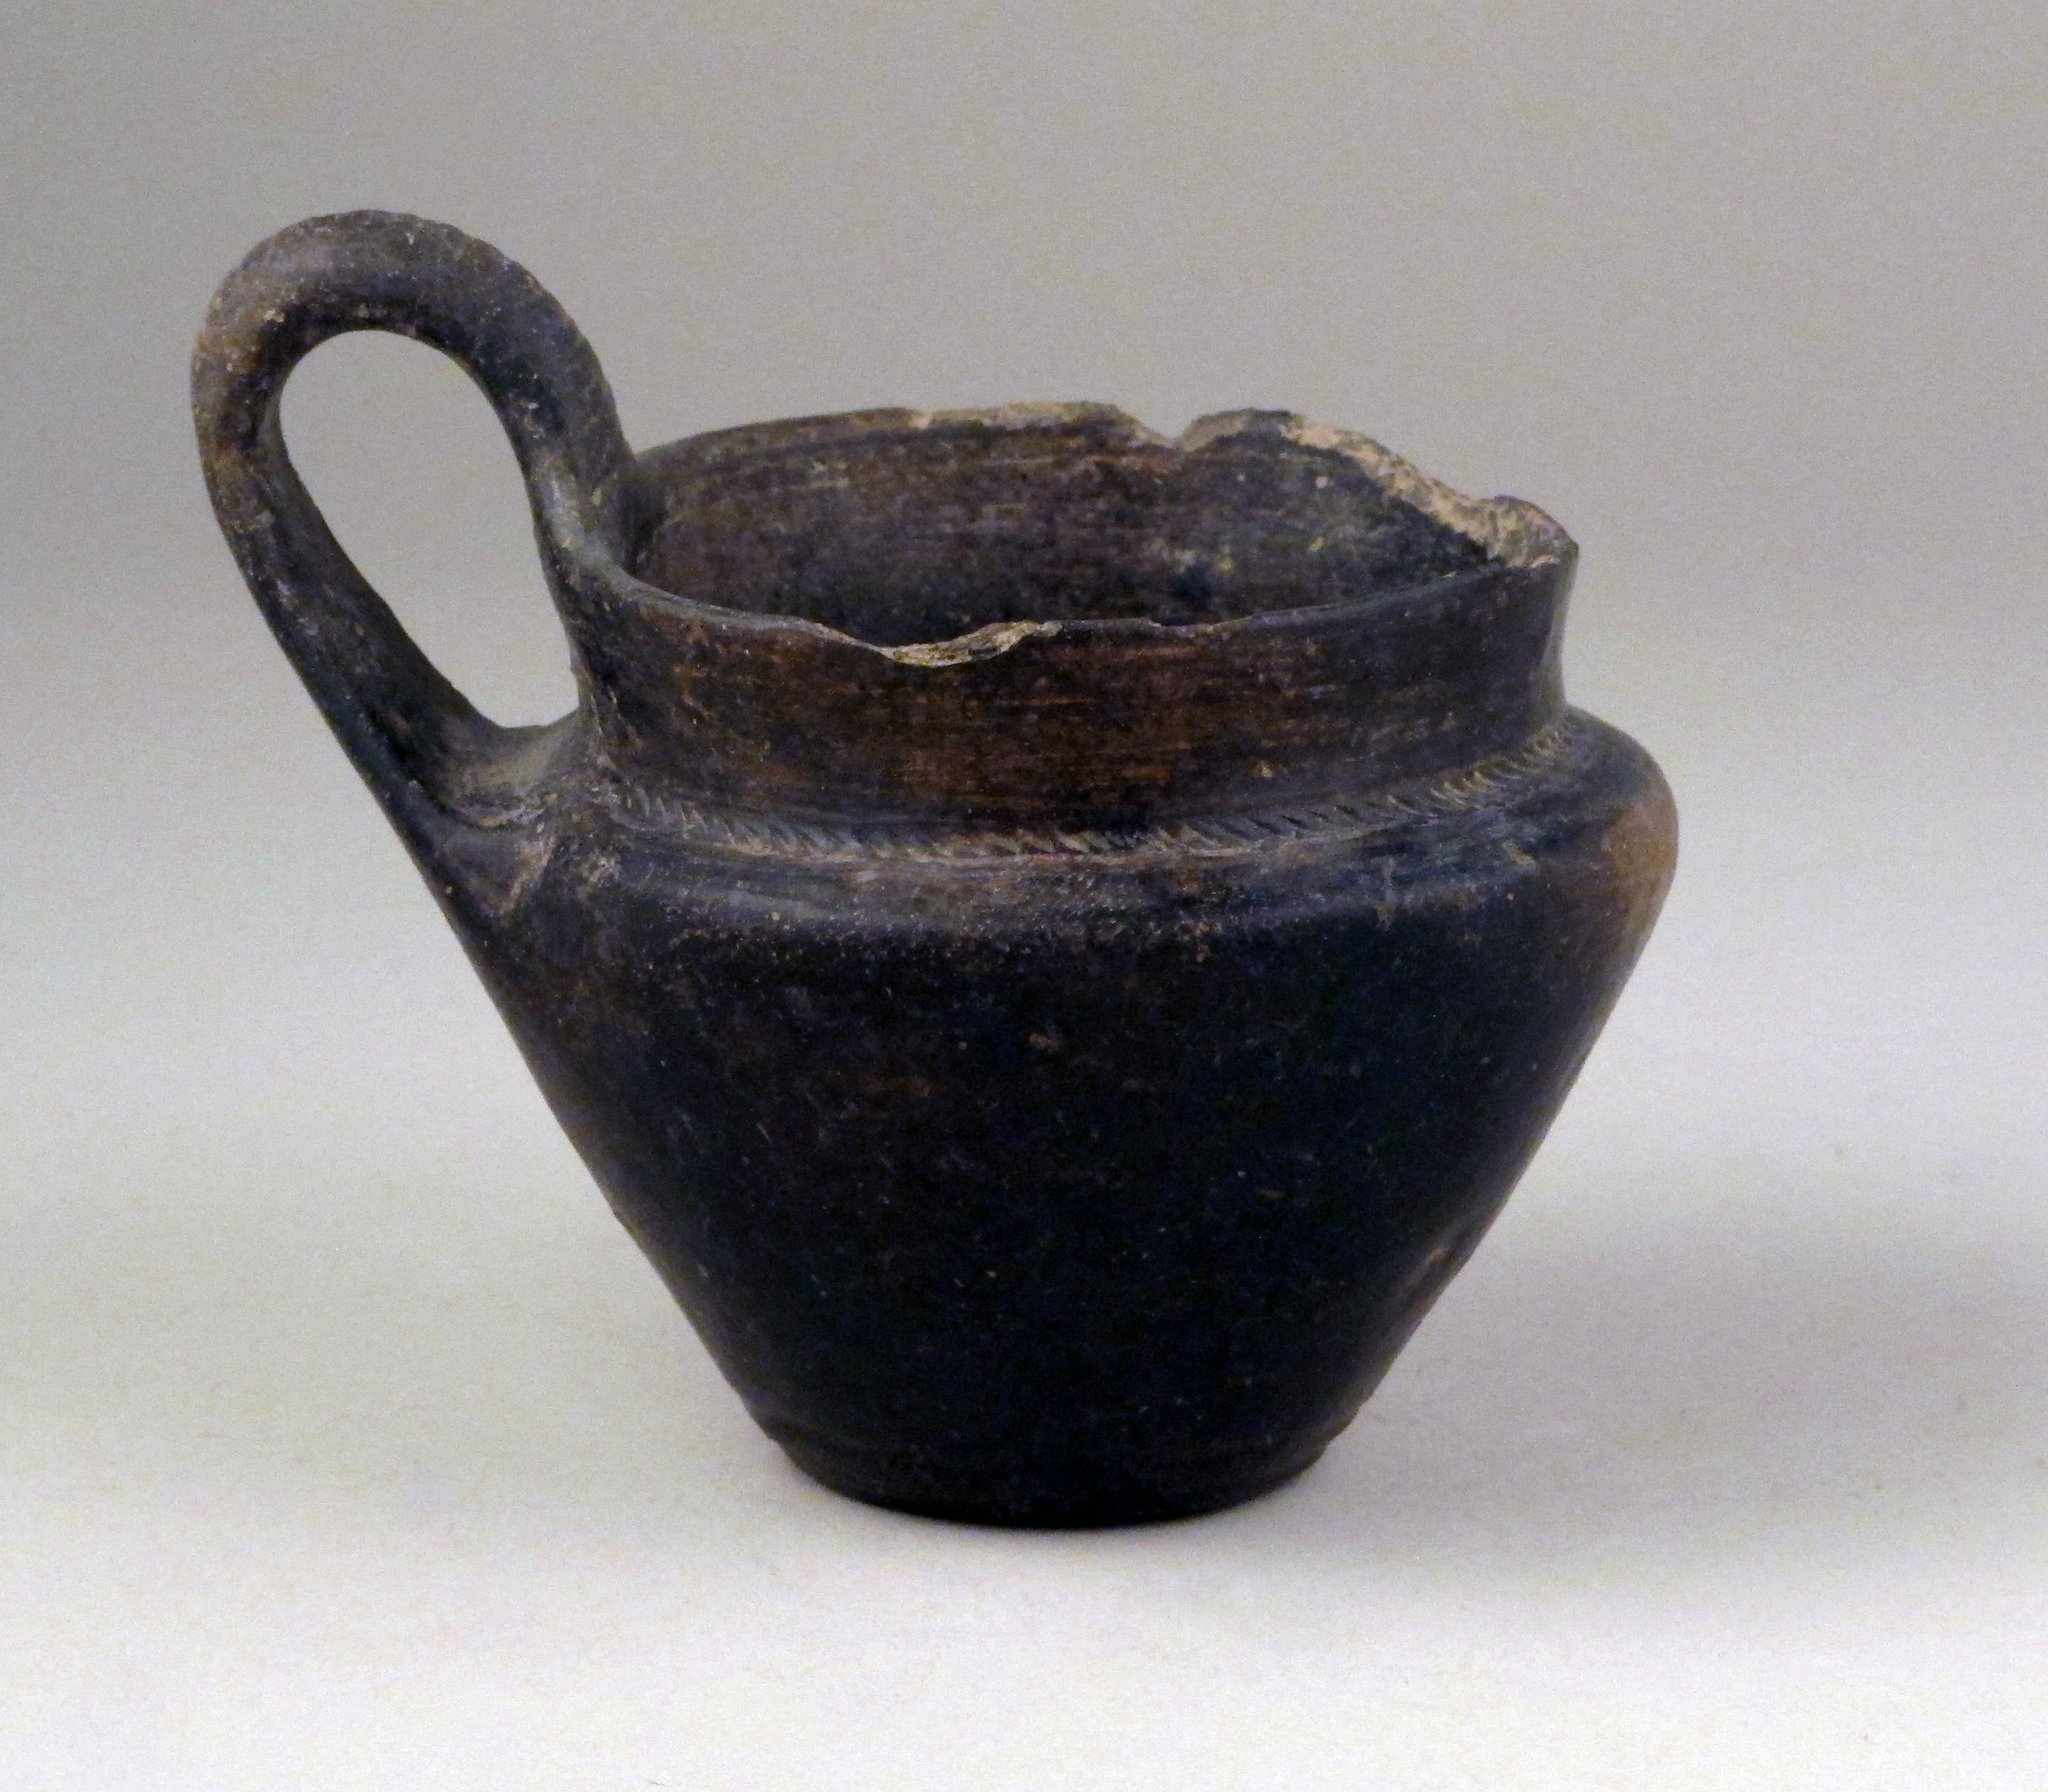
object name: cup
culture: italic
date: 900-100 BCE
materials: terracotta